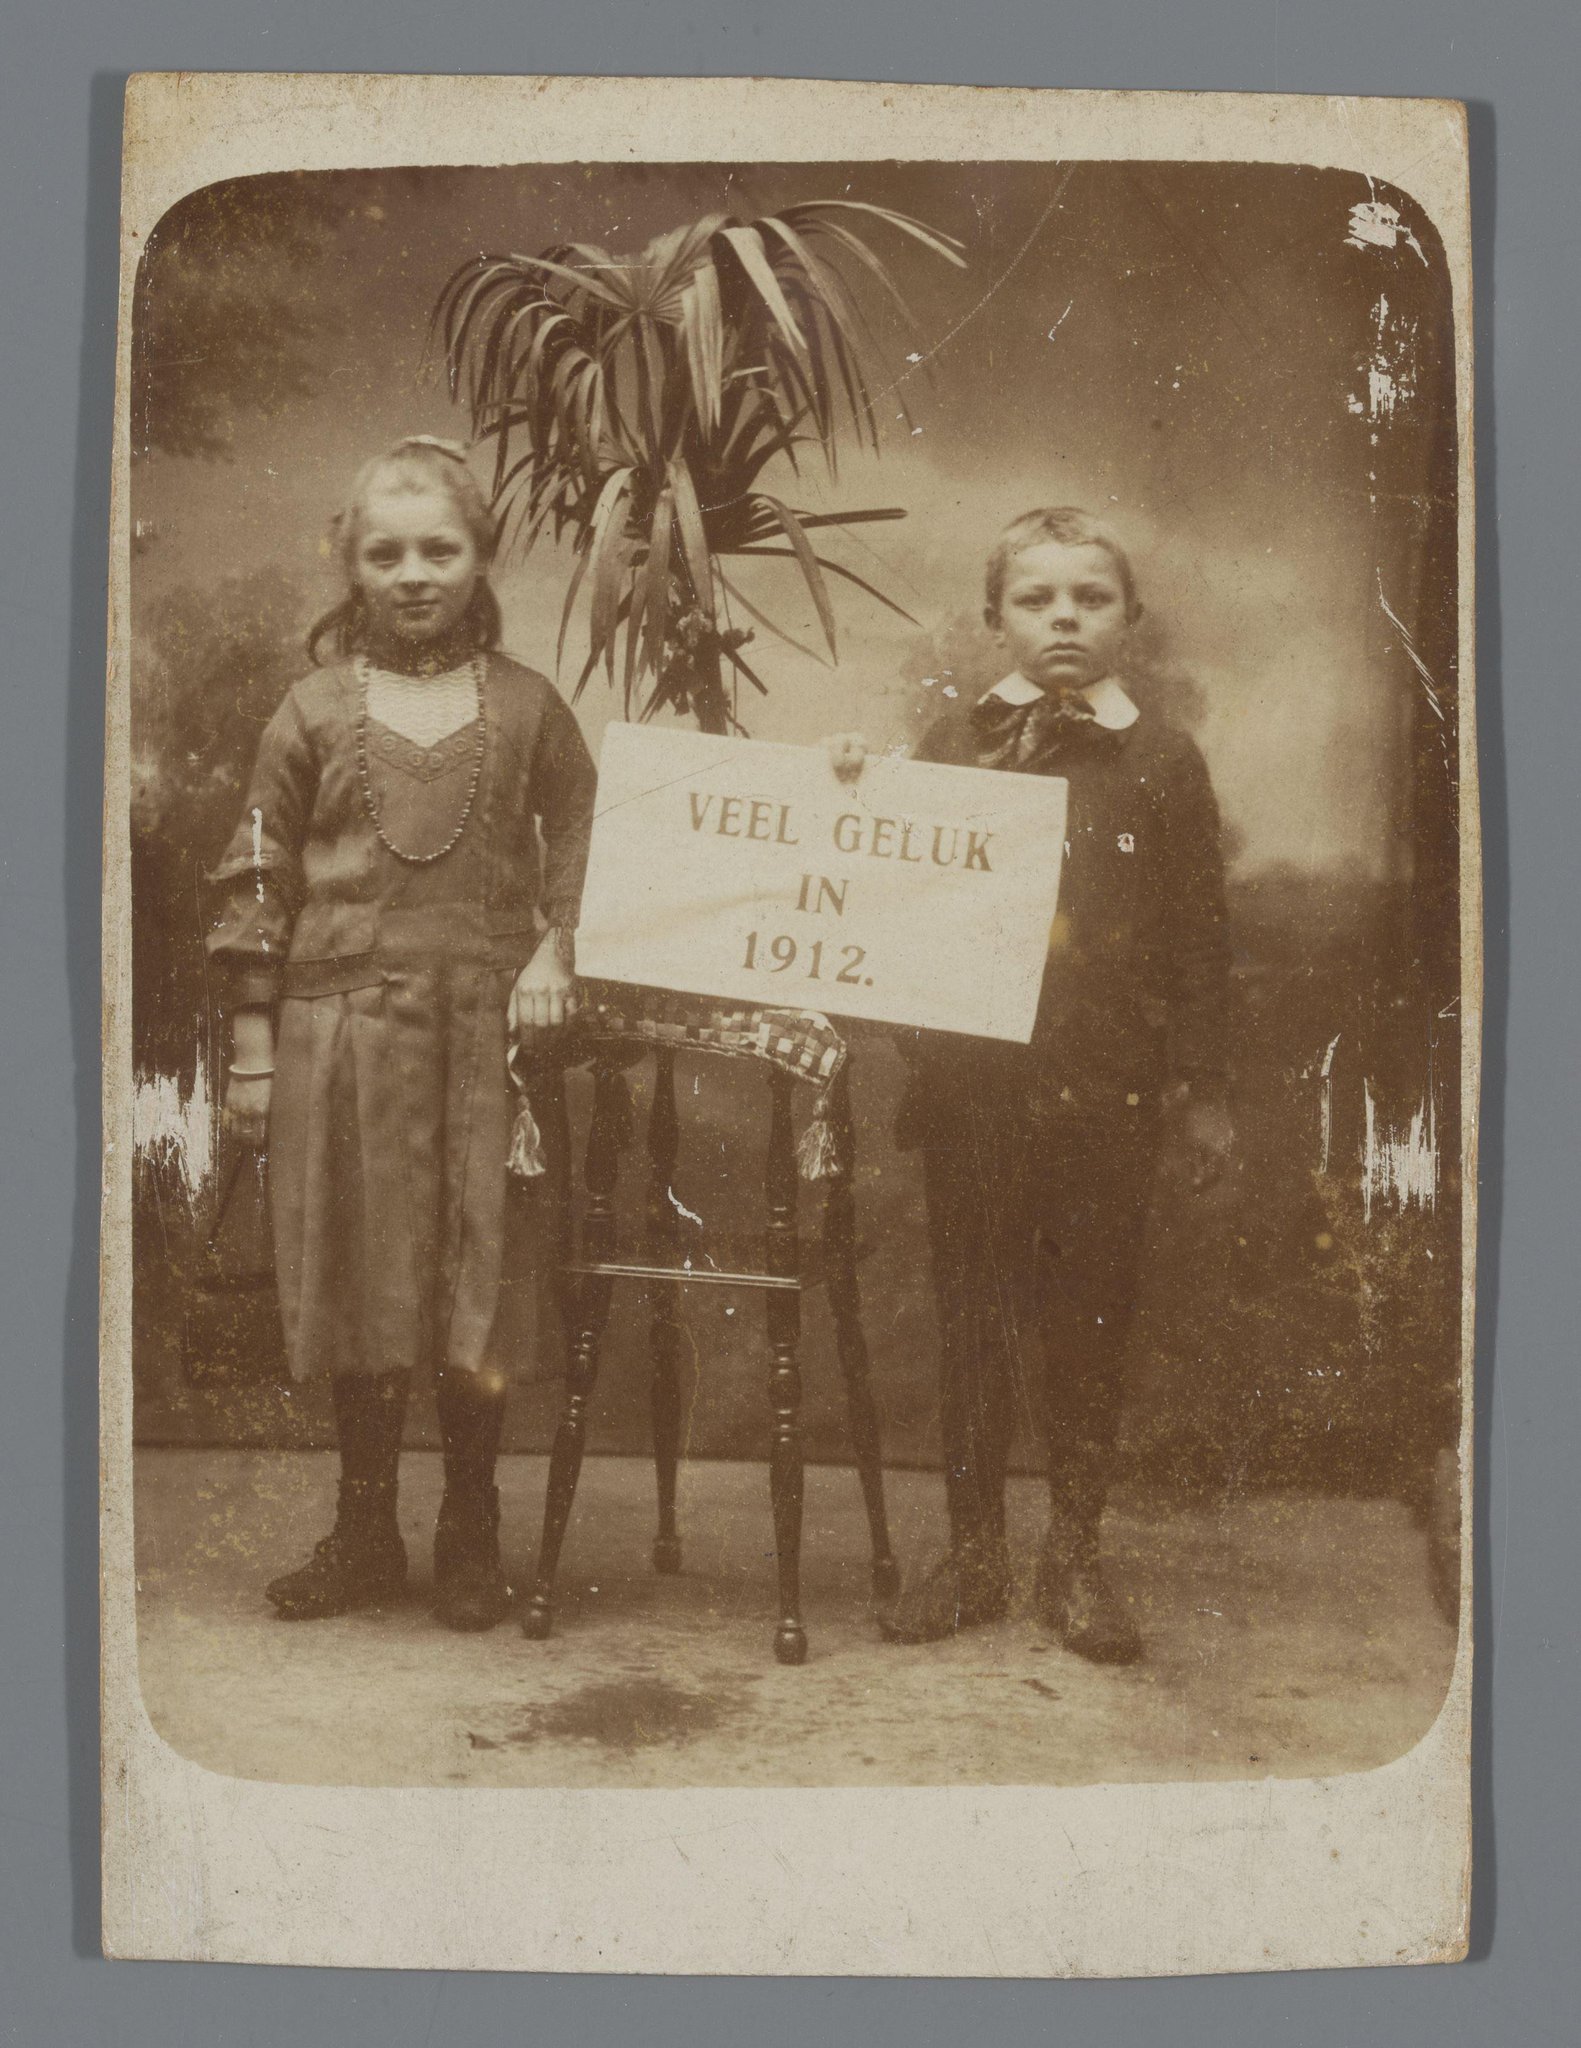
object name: photograph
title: Nieuwjaarswens voor het jaar 1912 met portret van een onbekende jongen en meisje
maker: Anonymous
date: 1911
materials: paper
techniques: collodion silver print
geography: netherlands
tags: child, anonymous historical person portrayed, netherlands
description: Portret van een jongen en meisje in een fotostudio met bord waarop de tekst 'Veel geluk in 1912'.